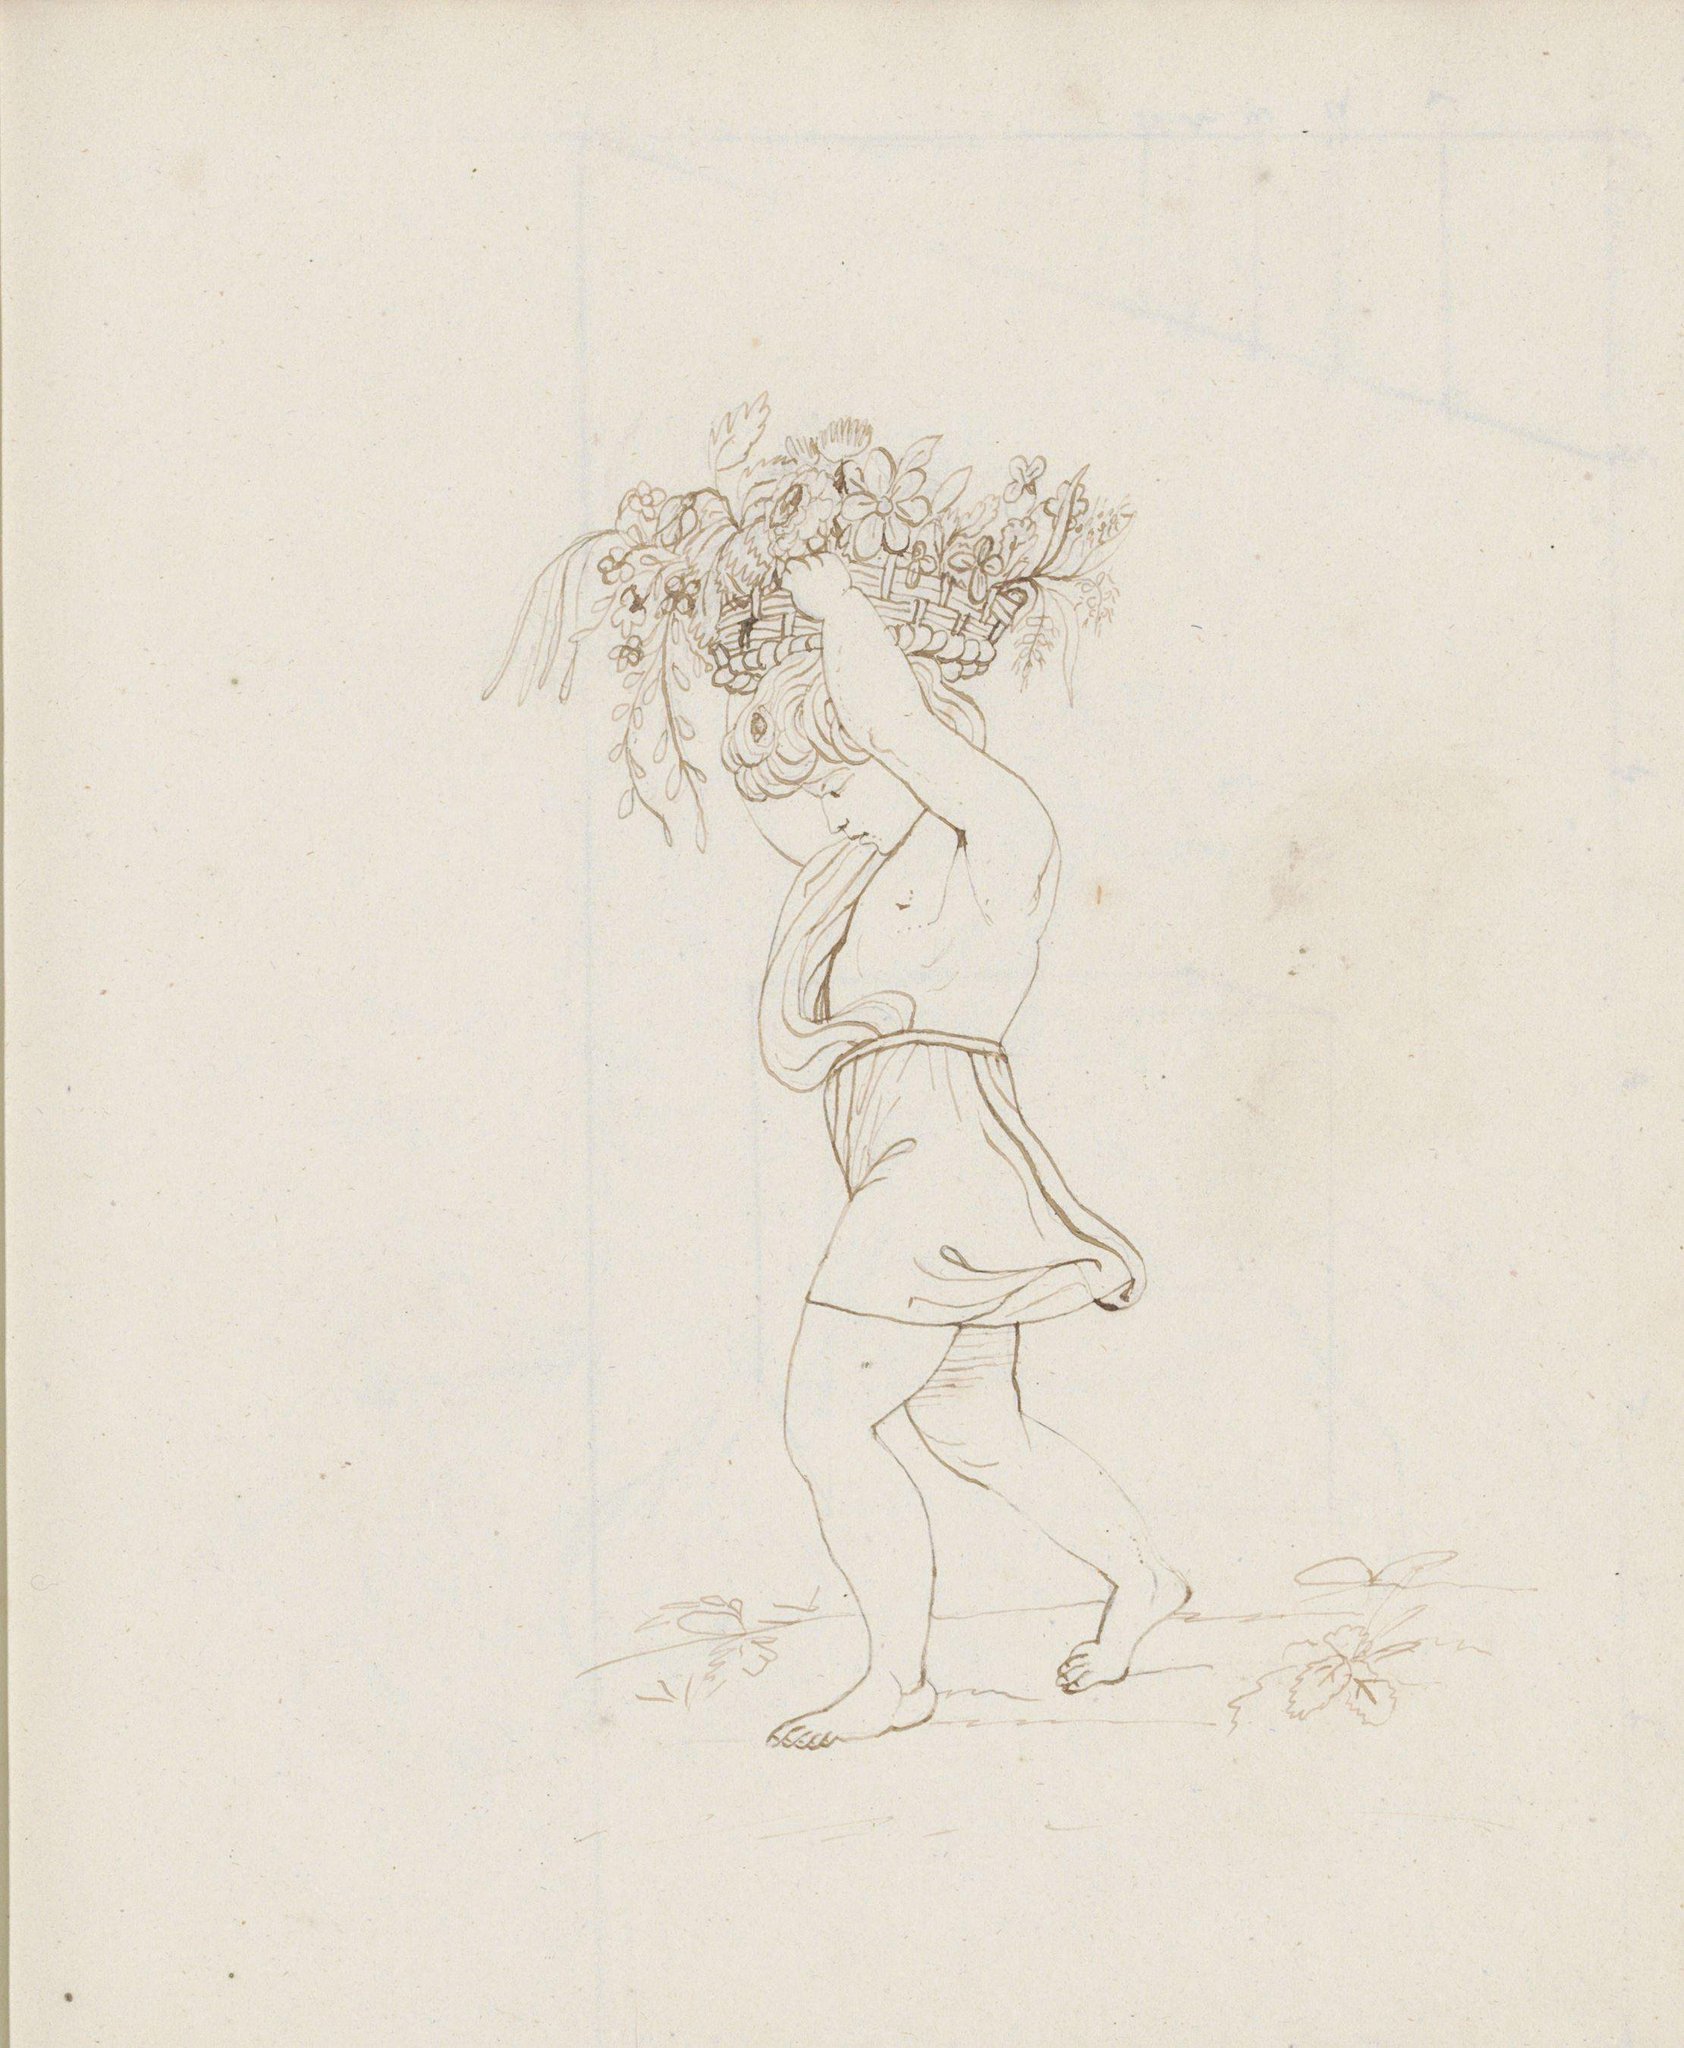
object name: sketchbook leaf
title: Putto die een bloemenmand op het hoofd draagt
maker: jonkvrouw catharina kemper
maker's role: draughtsman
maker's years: 1801-1871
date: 1813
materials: ink, paper, pencil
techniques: pen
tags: flowers, carrying something in basket, bag, rucksack, etc., cupids: 'amores', 'amoretti', 'putti'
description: Blad 27 recto uit een schetsboek met 91 bladen.